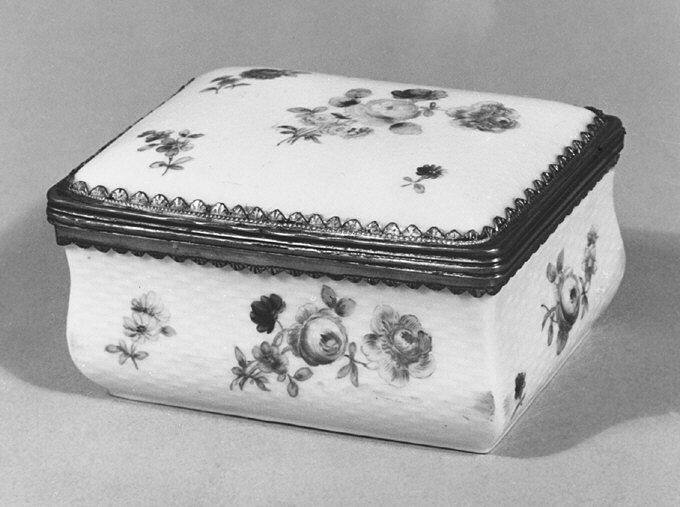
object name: snuffbox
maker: royal porcelain manufactory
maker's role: factory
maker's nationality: danish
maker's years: 1775-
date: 1775-1780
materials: hard paste porcelain, silver gilt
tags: flowers